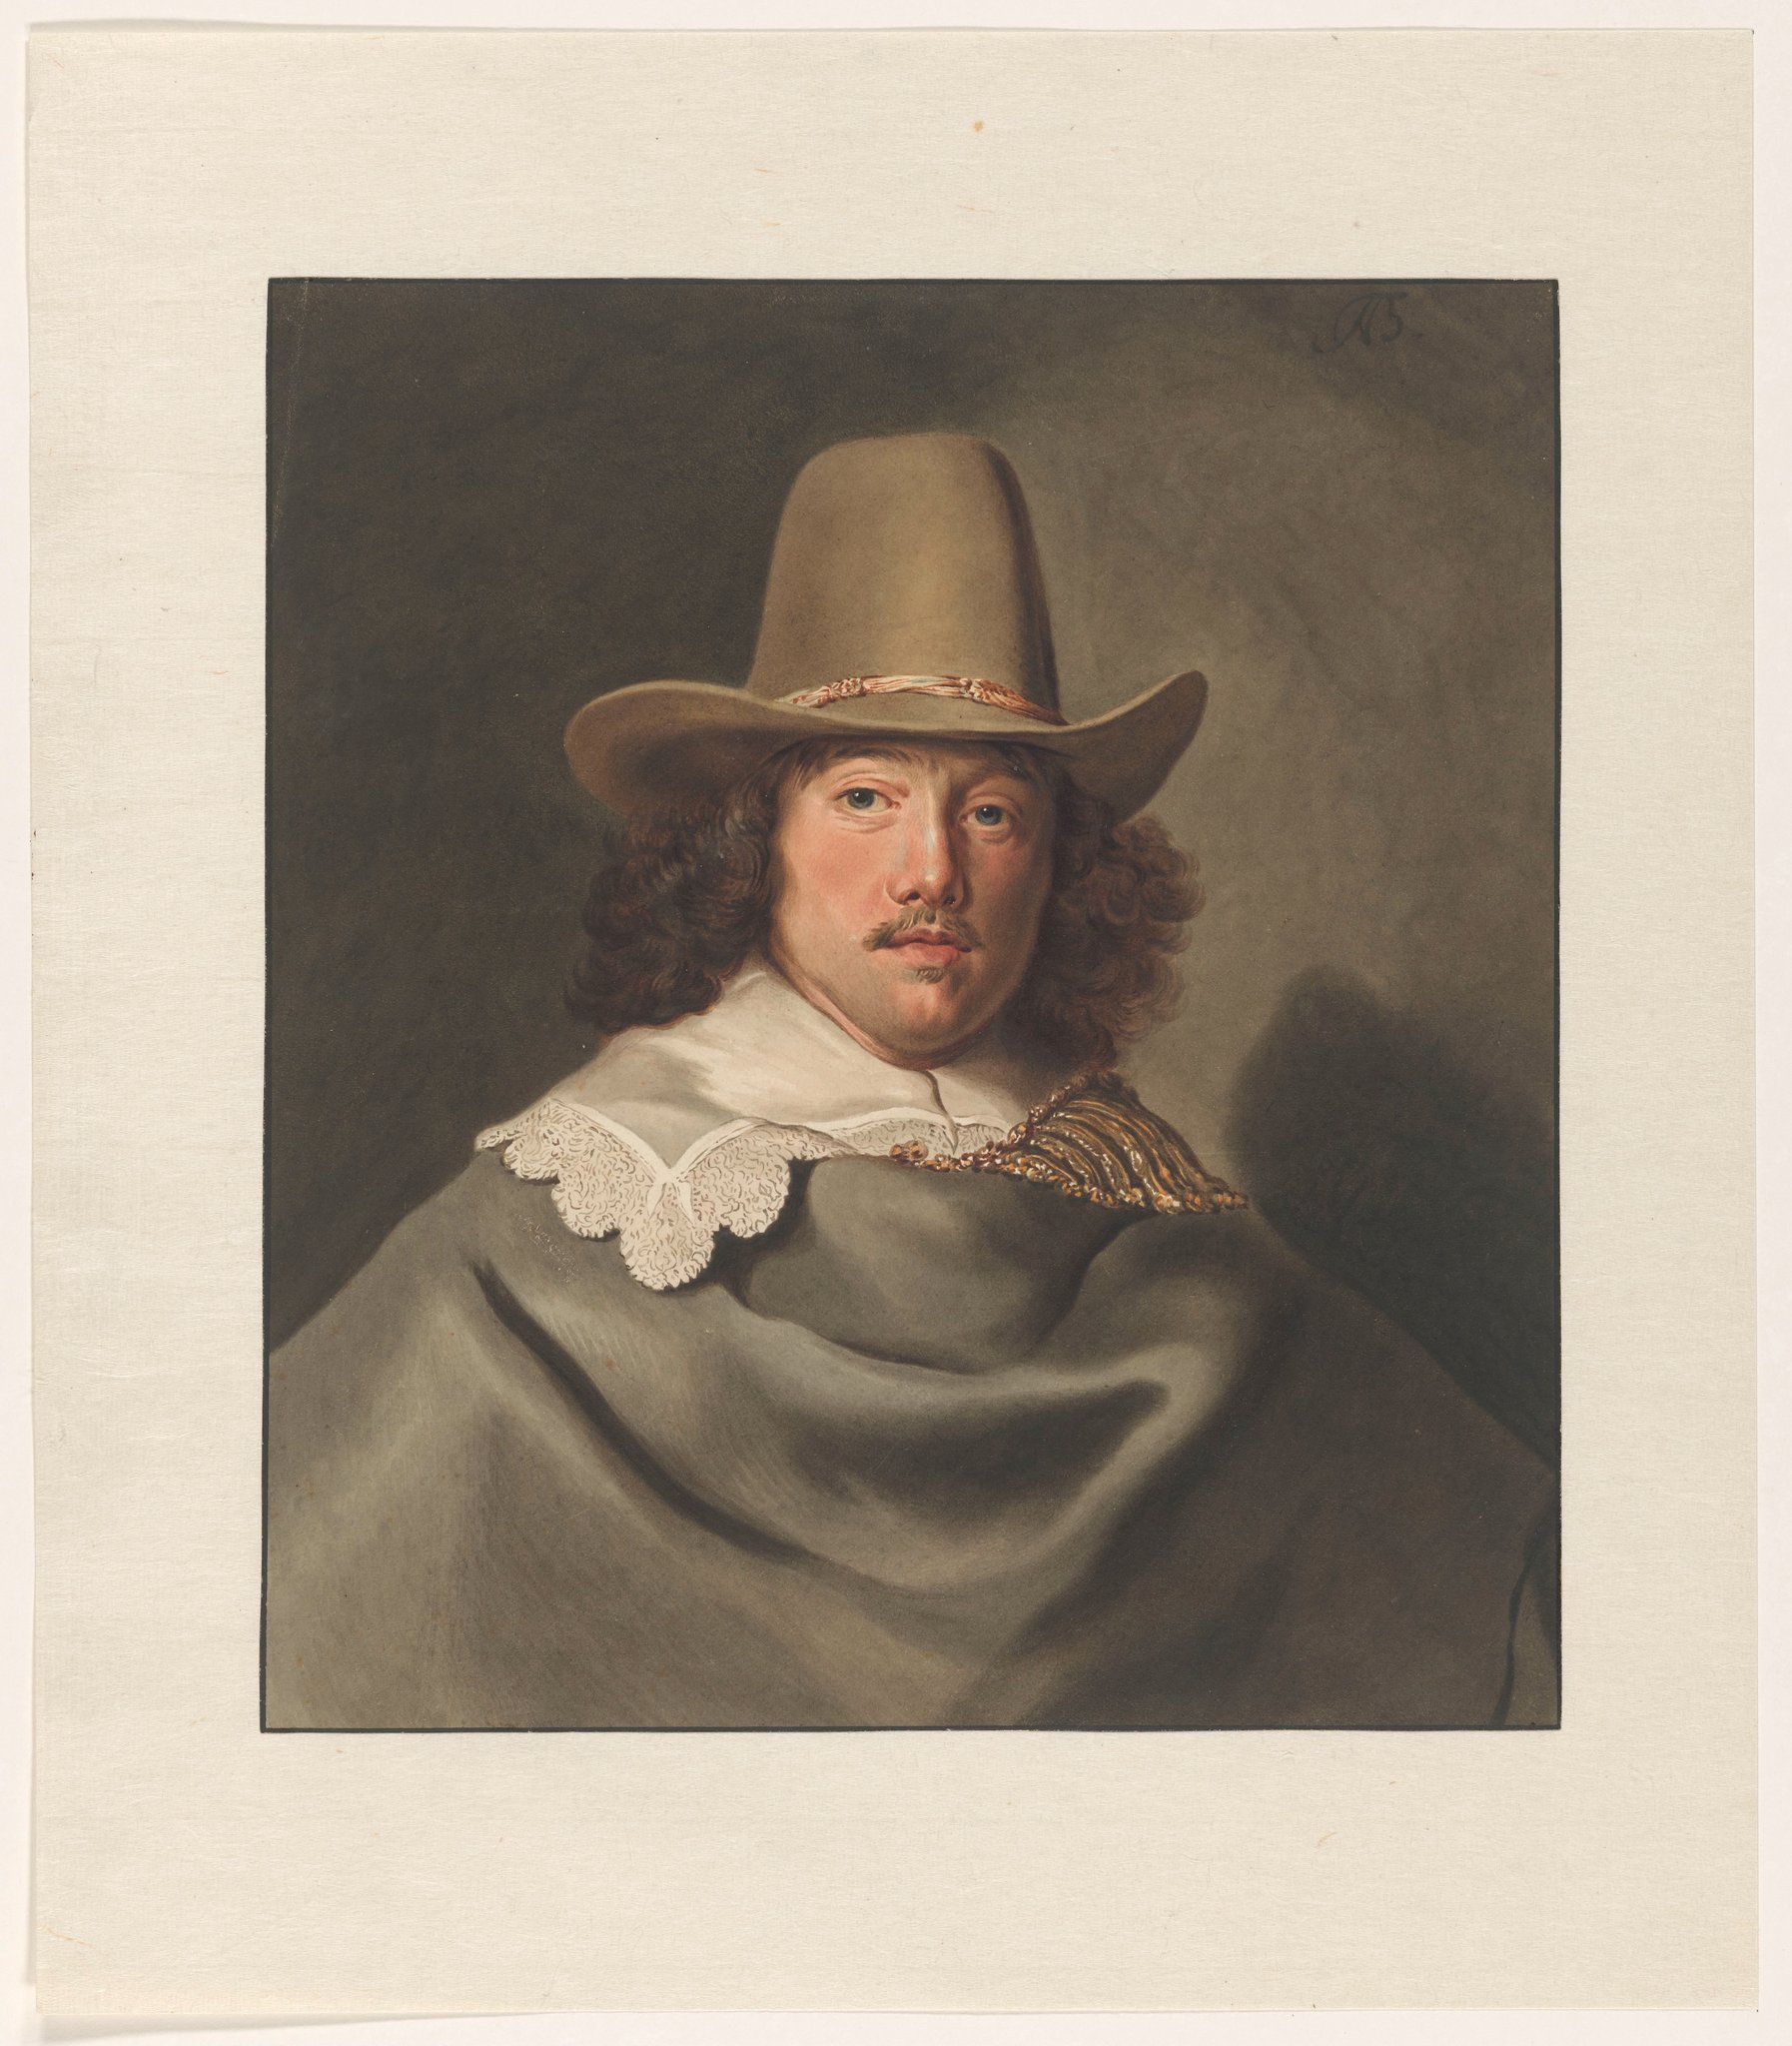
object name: watercolor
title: Portret van Abraham Velters (1603-1690)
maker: christiaan kramm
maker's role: draughtsman, print maker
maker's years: 1797-1875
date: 1822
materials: paper, watercolor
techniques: brush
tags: amsterdam, historical persons